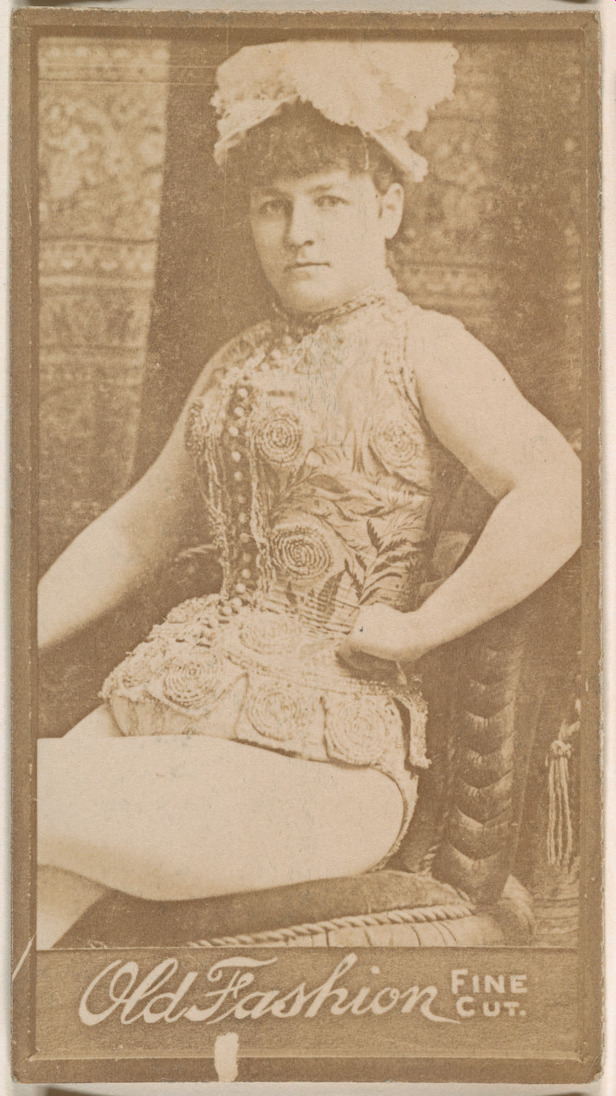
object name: photograph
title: Actress seated in chair, from the Actresses series (N664) promoting Old Fashion Fine Cut Tobacco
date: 1888-1890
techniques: albumen silver print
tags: portraits,women,actresses